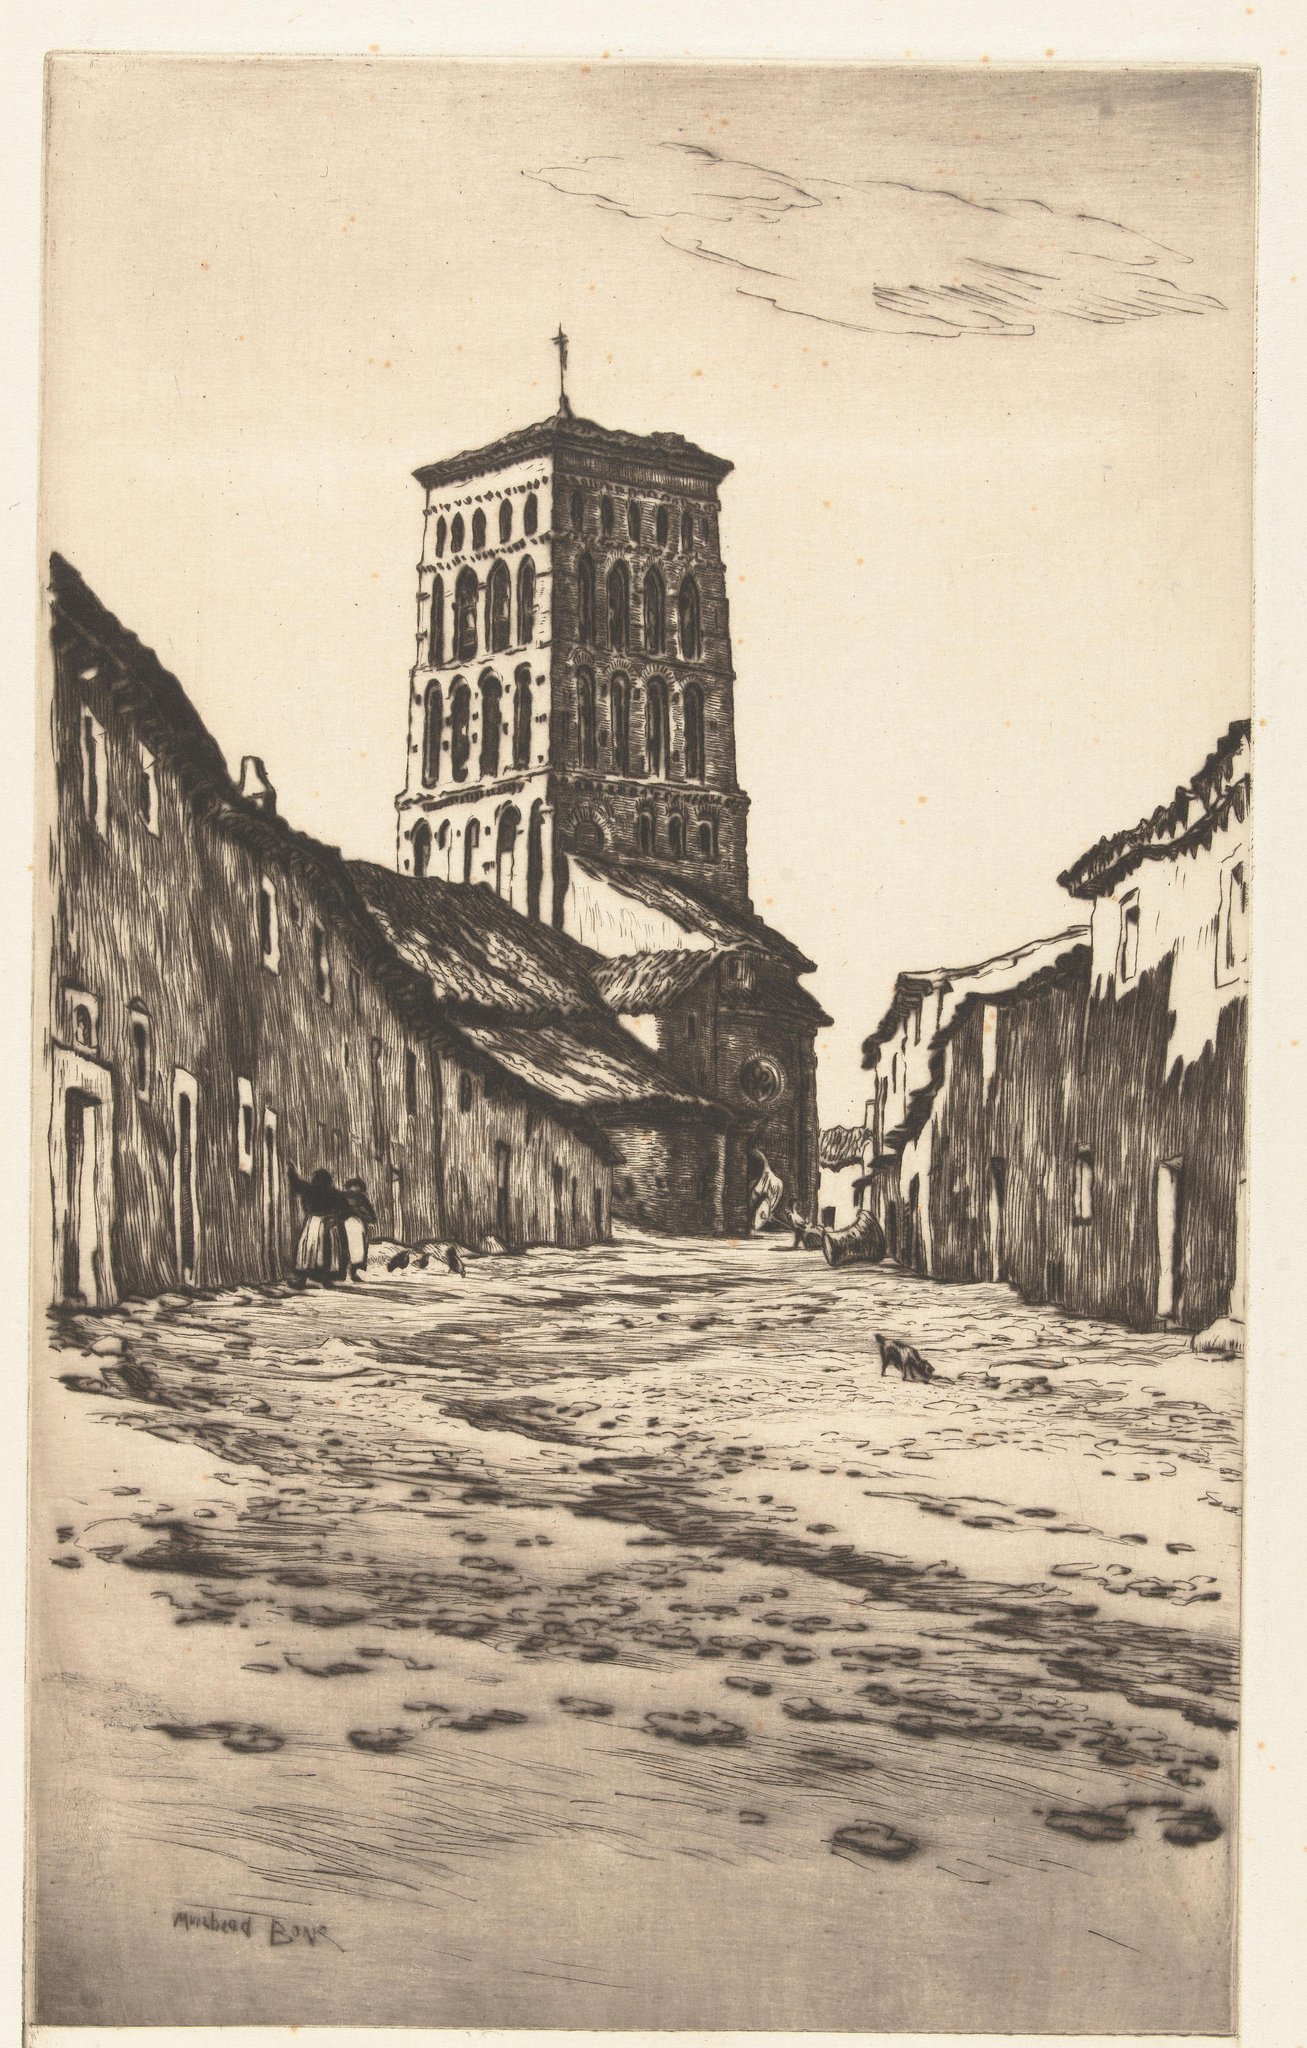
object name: print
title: Afternoon, Sahagún, Spain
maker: muirhead bone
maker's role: artist, print maker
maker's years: 1876-1953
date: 1929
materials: paper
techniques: drypoint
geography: england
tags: church (exterior), public road in village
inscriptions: signature: ‘Muirhead Bone’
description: Het Spaanse dorp Sahagún. Een onverharde weg, geflankeerd door lage huizen, eindigend bij de kerk van San Lorenzo, met een hoge romaanse toren.